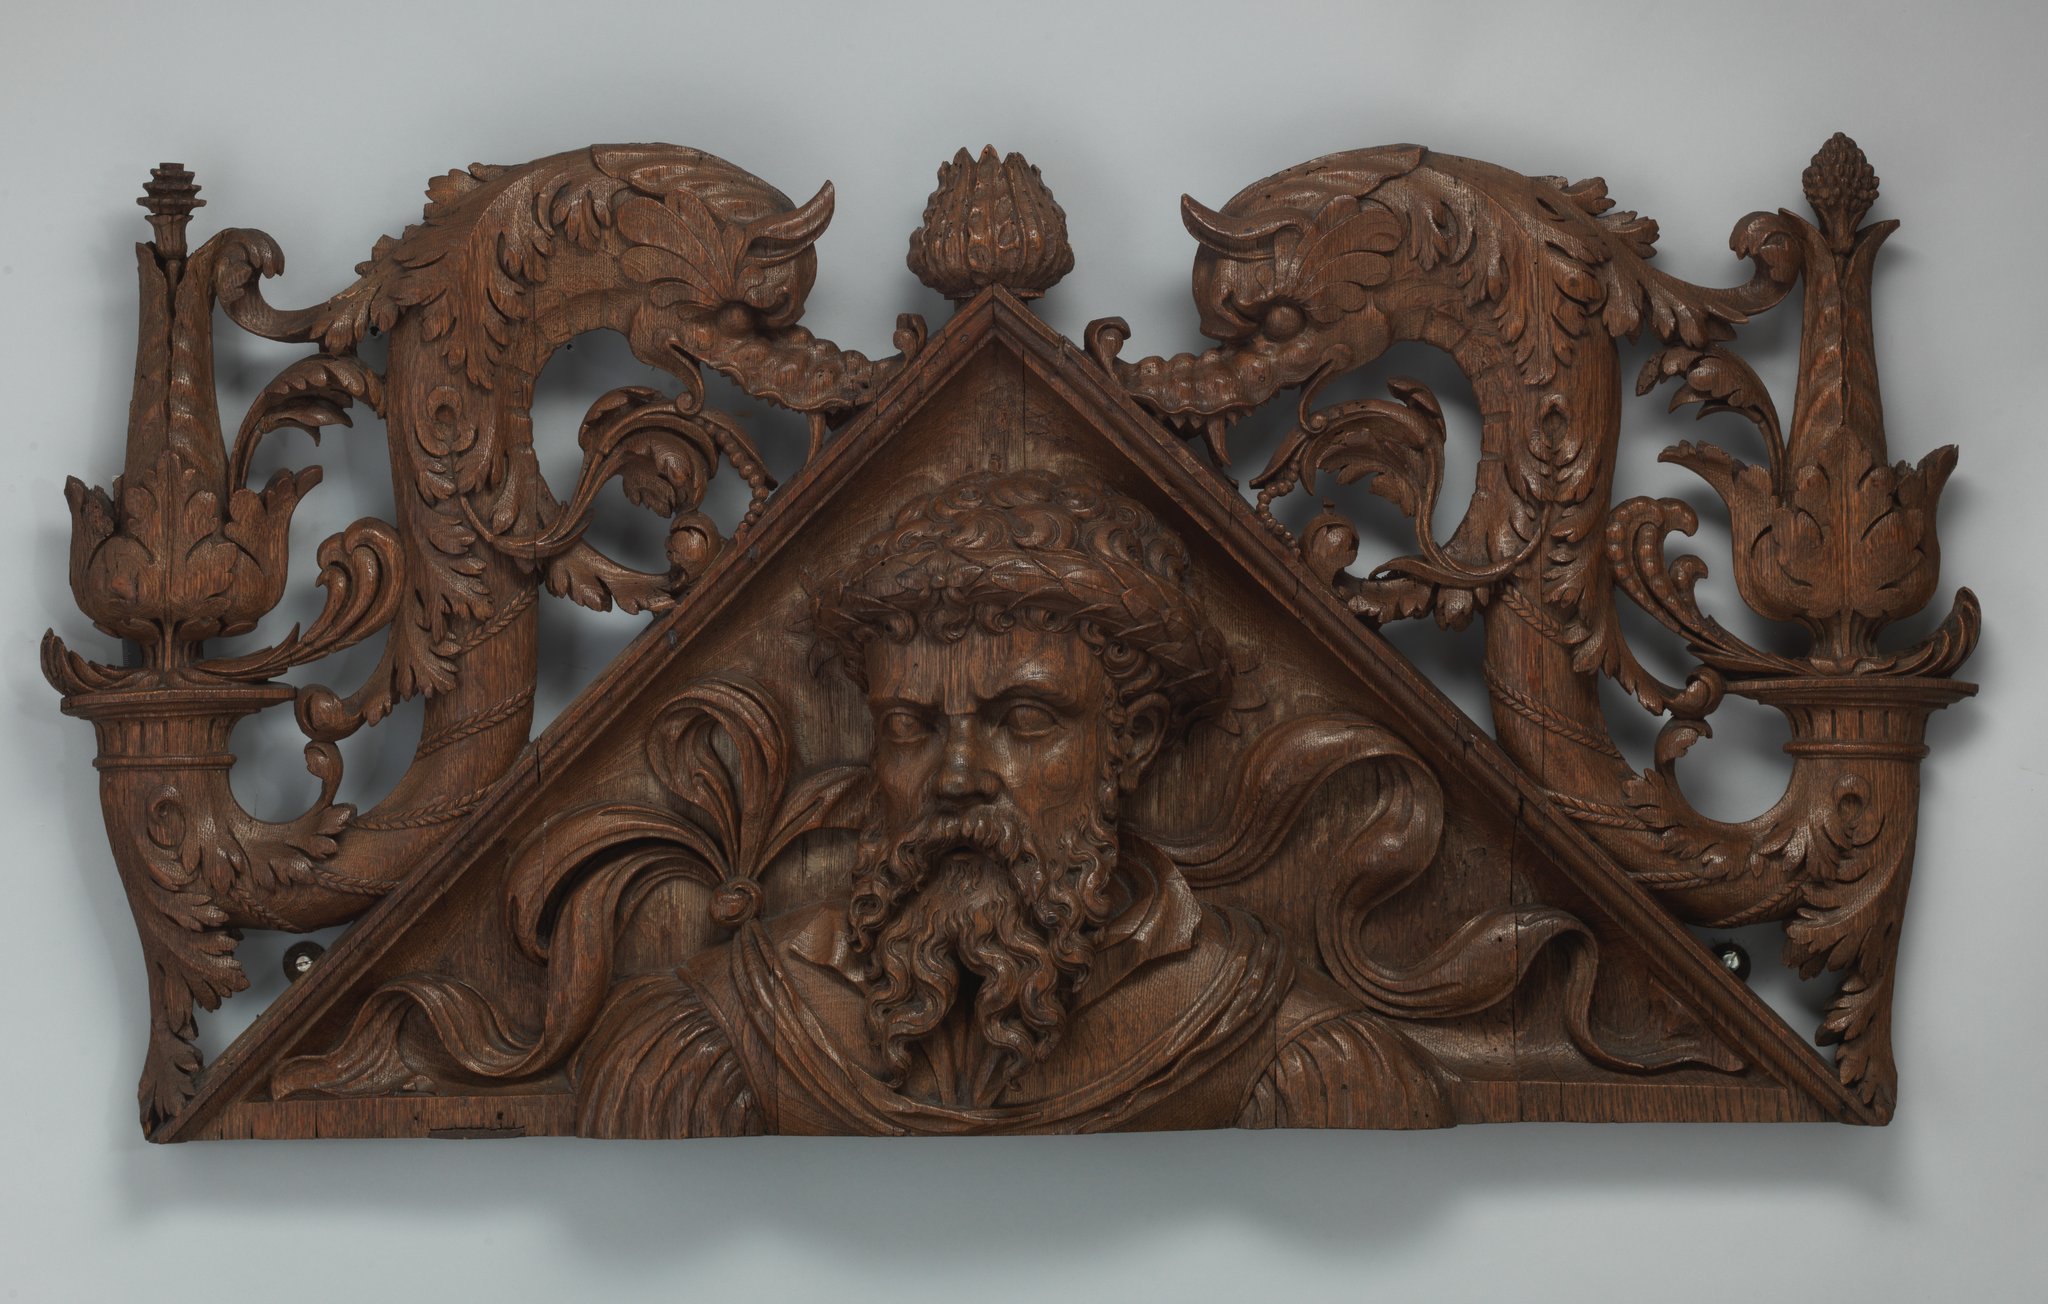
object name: pediment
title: Pediment (one of a pair)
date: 1525-1530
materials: wood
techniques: carving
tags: men